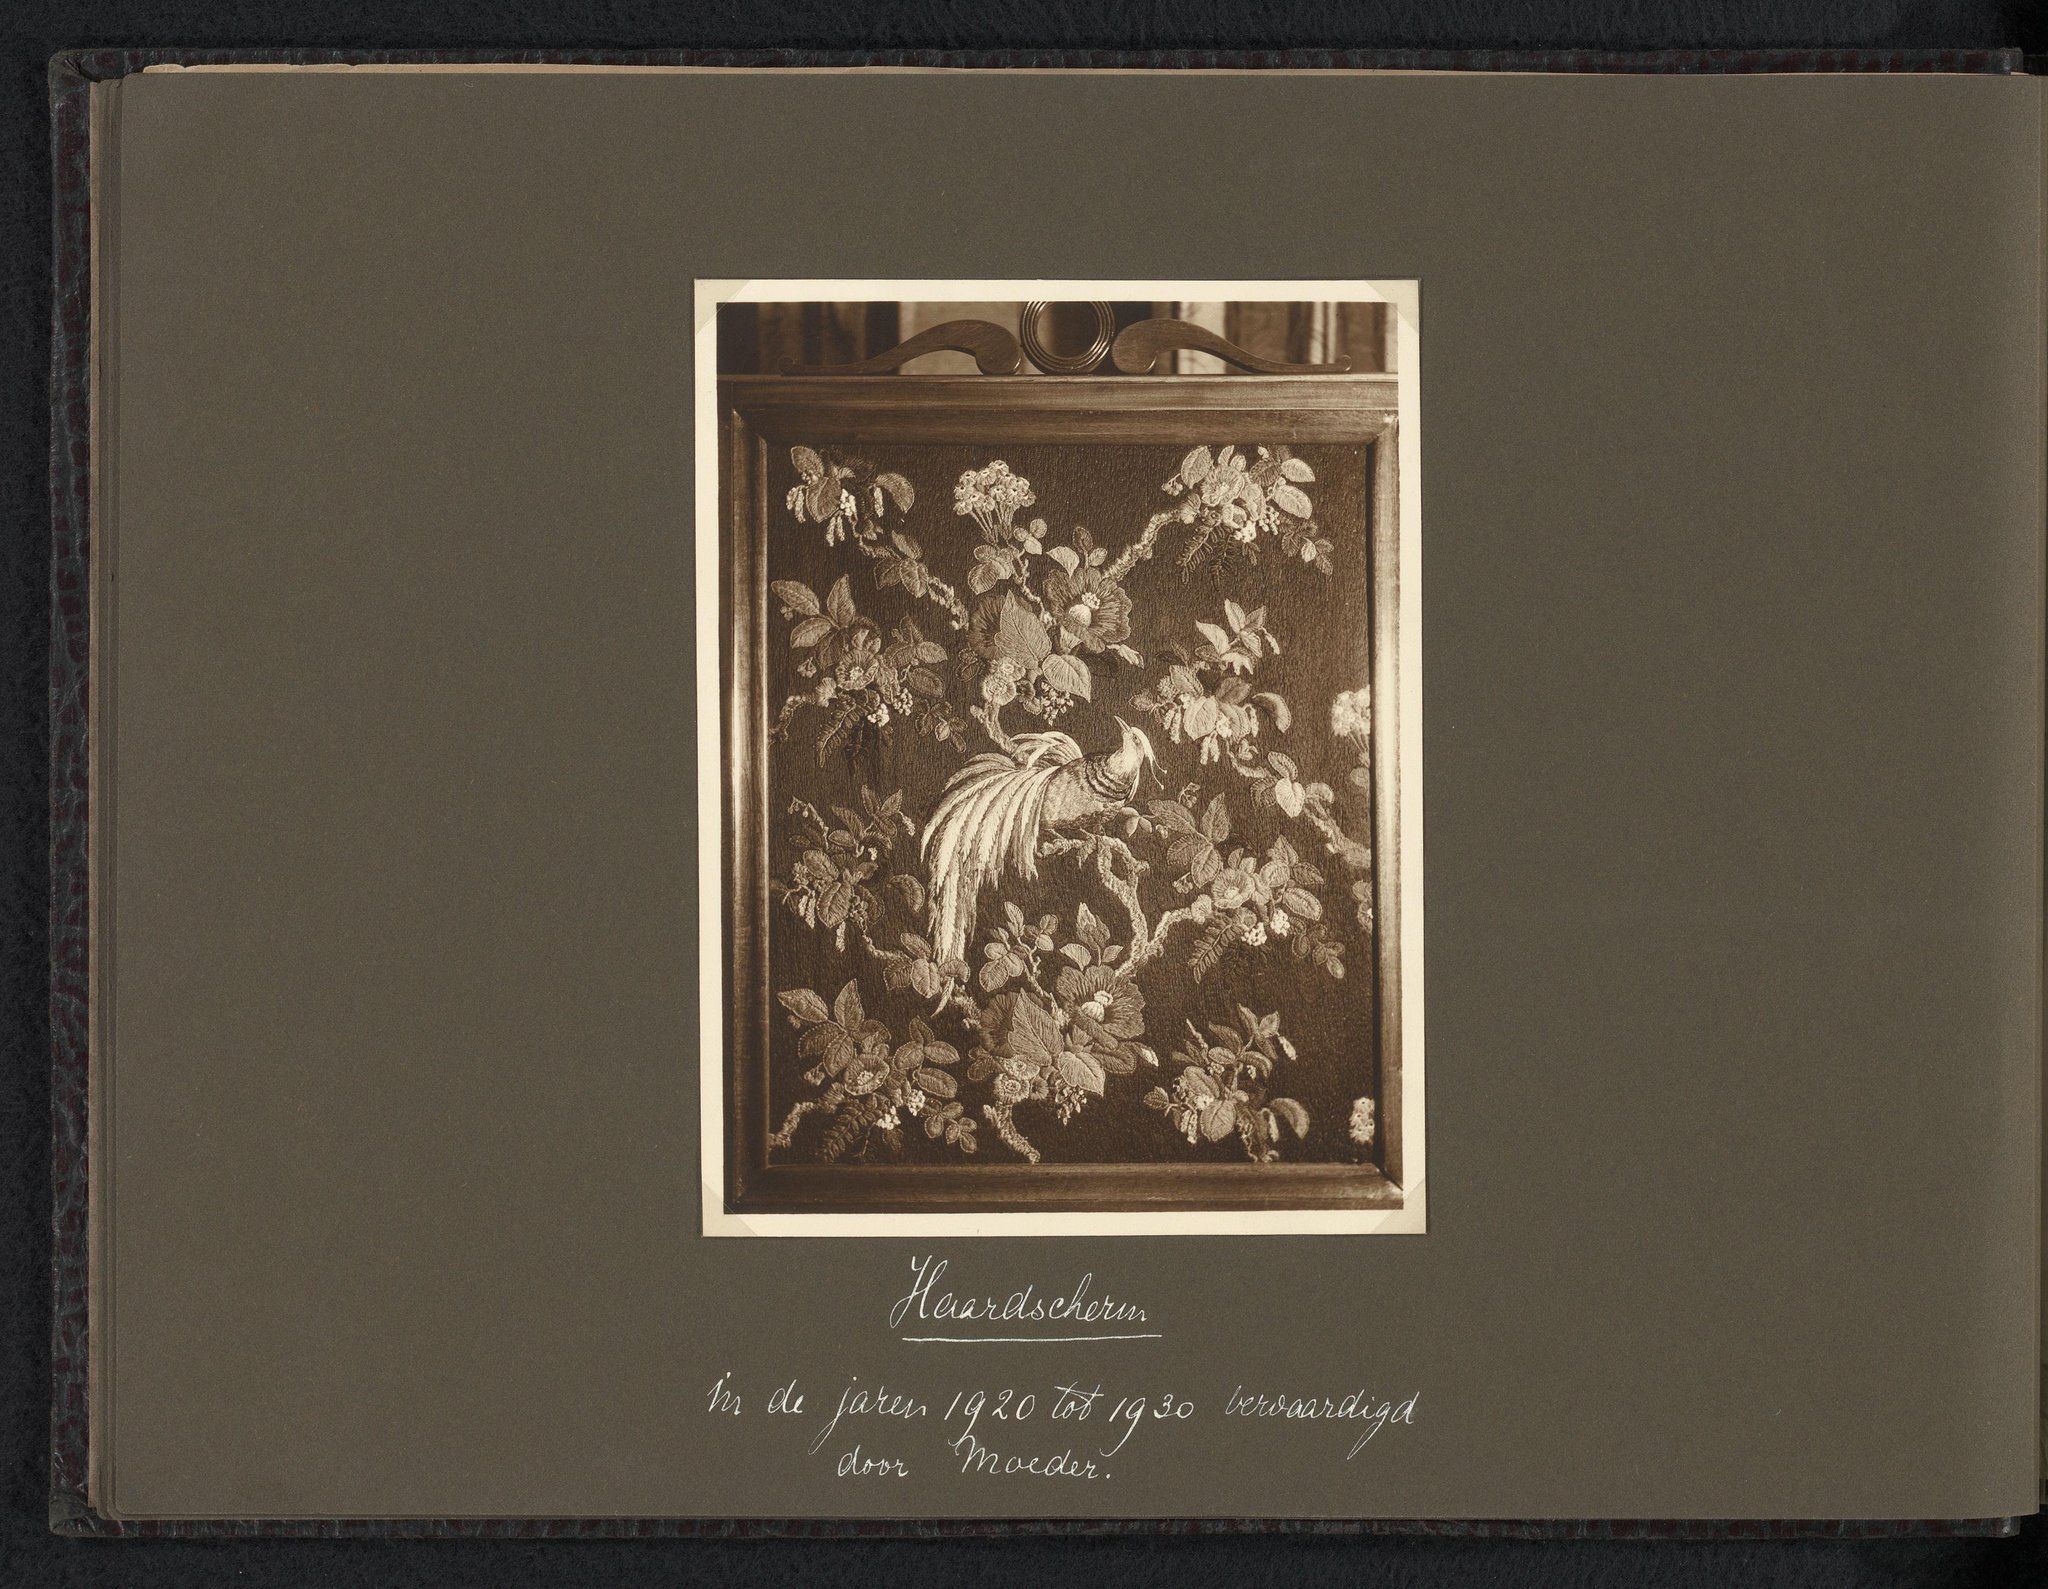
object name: photograph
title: Haardscherm met decoratie van een vogel in een bloesemboom, Keizersgracht 806-808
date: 1930-1931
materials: paper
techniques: gelatin silver print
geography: amsterdam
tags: birds, (other forms of) needlework, e.g.: crocheting, knitting, embroidering